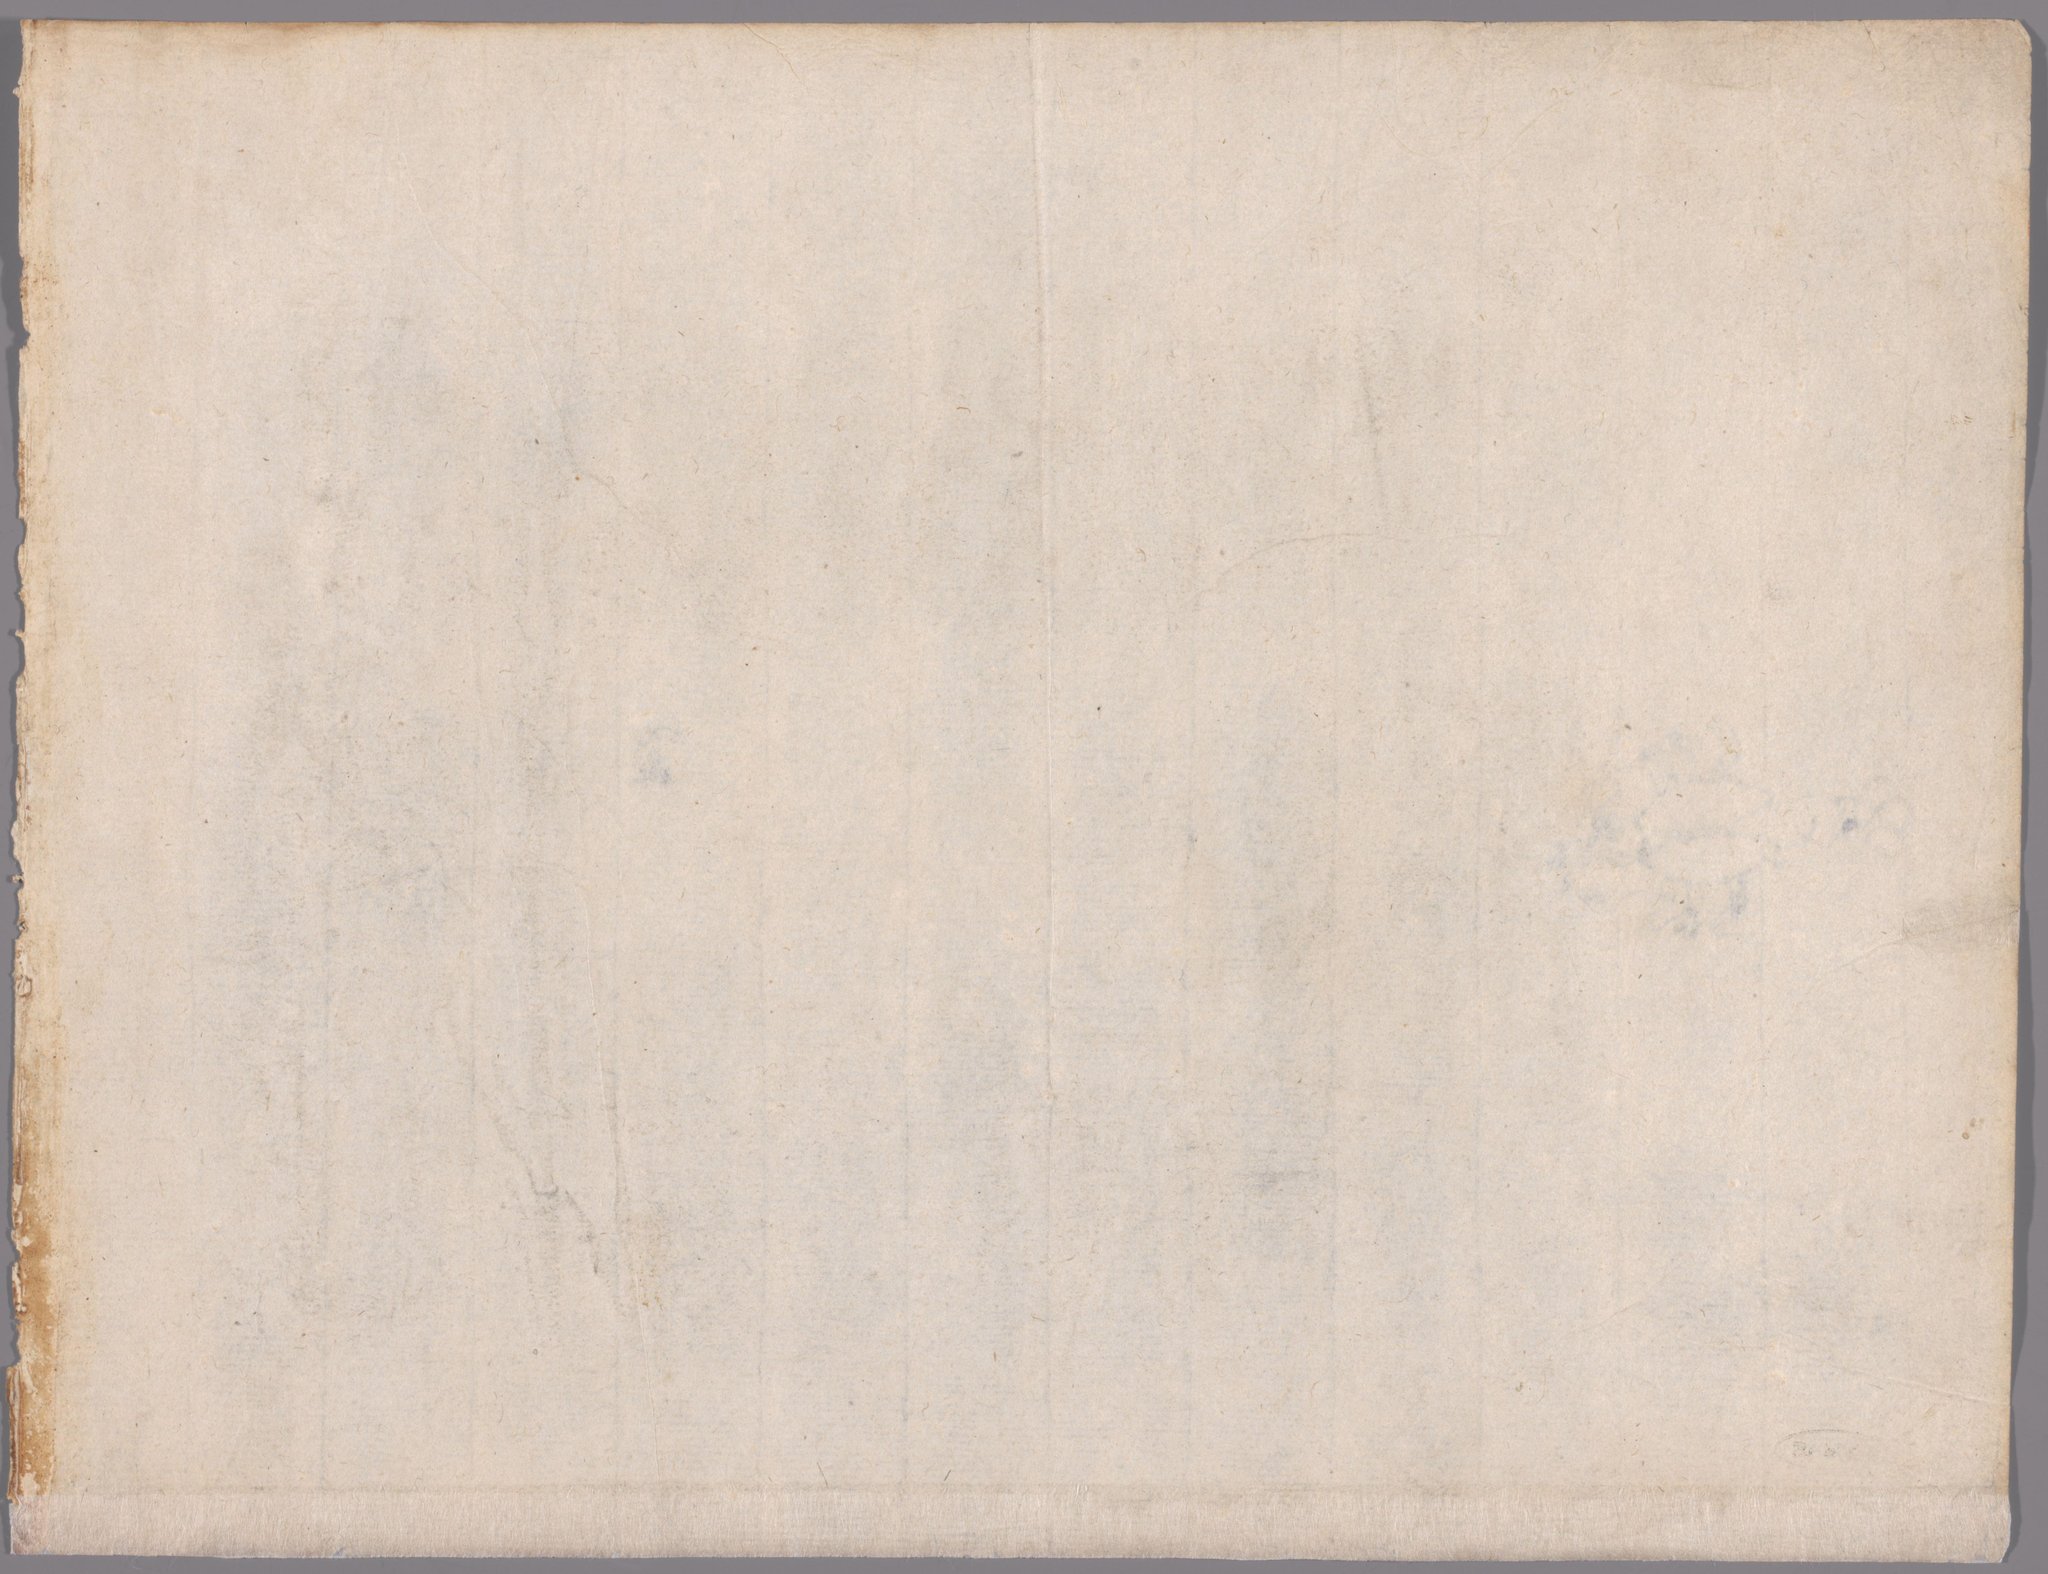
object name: endleaf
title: Schutblad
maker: Anonymous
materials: paper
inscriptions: watermark:, collector's mark: Lugt 2228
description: Deel van een ontmanteld album waarvan RP-P-2013-1-54-1 t/m -37, RP-P-2013-1-55-1 en -2 en RP-P-2013-1-63 t/m 67 deel waren.